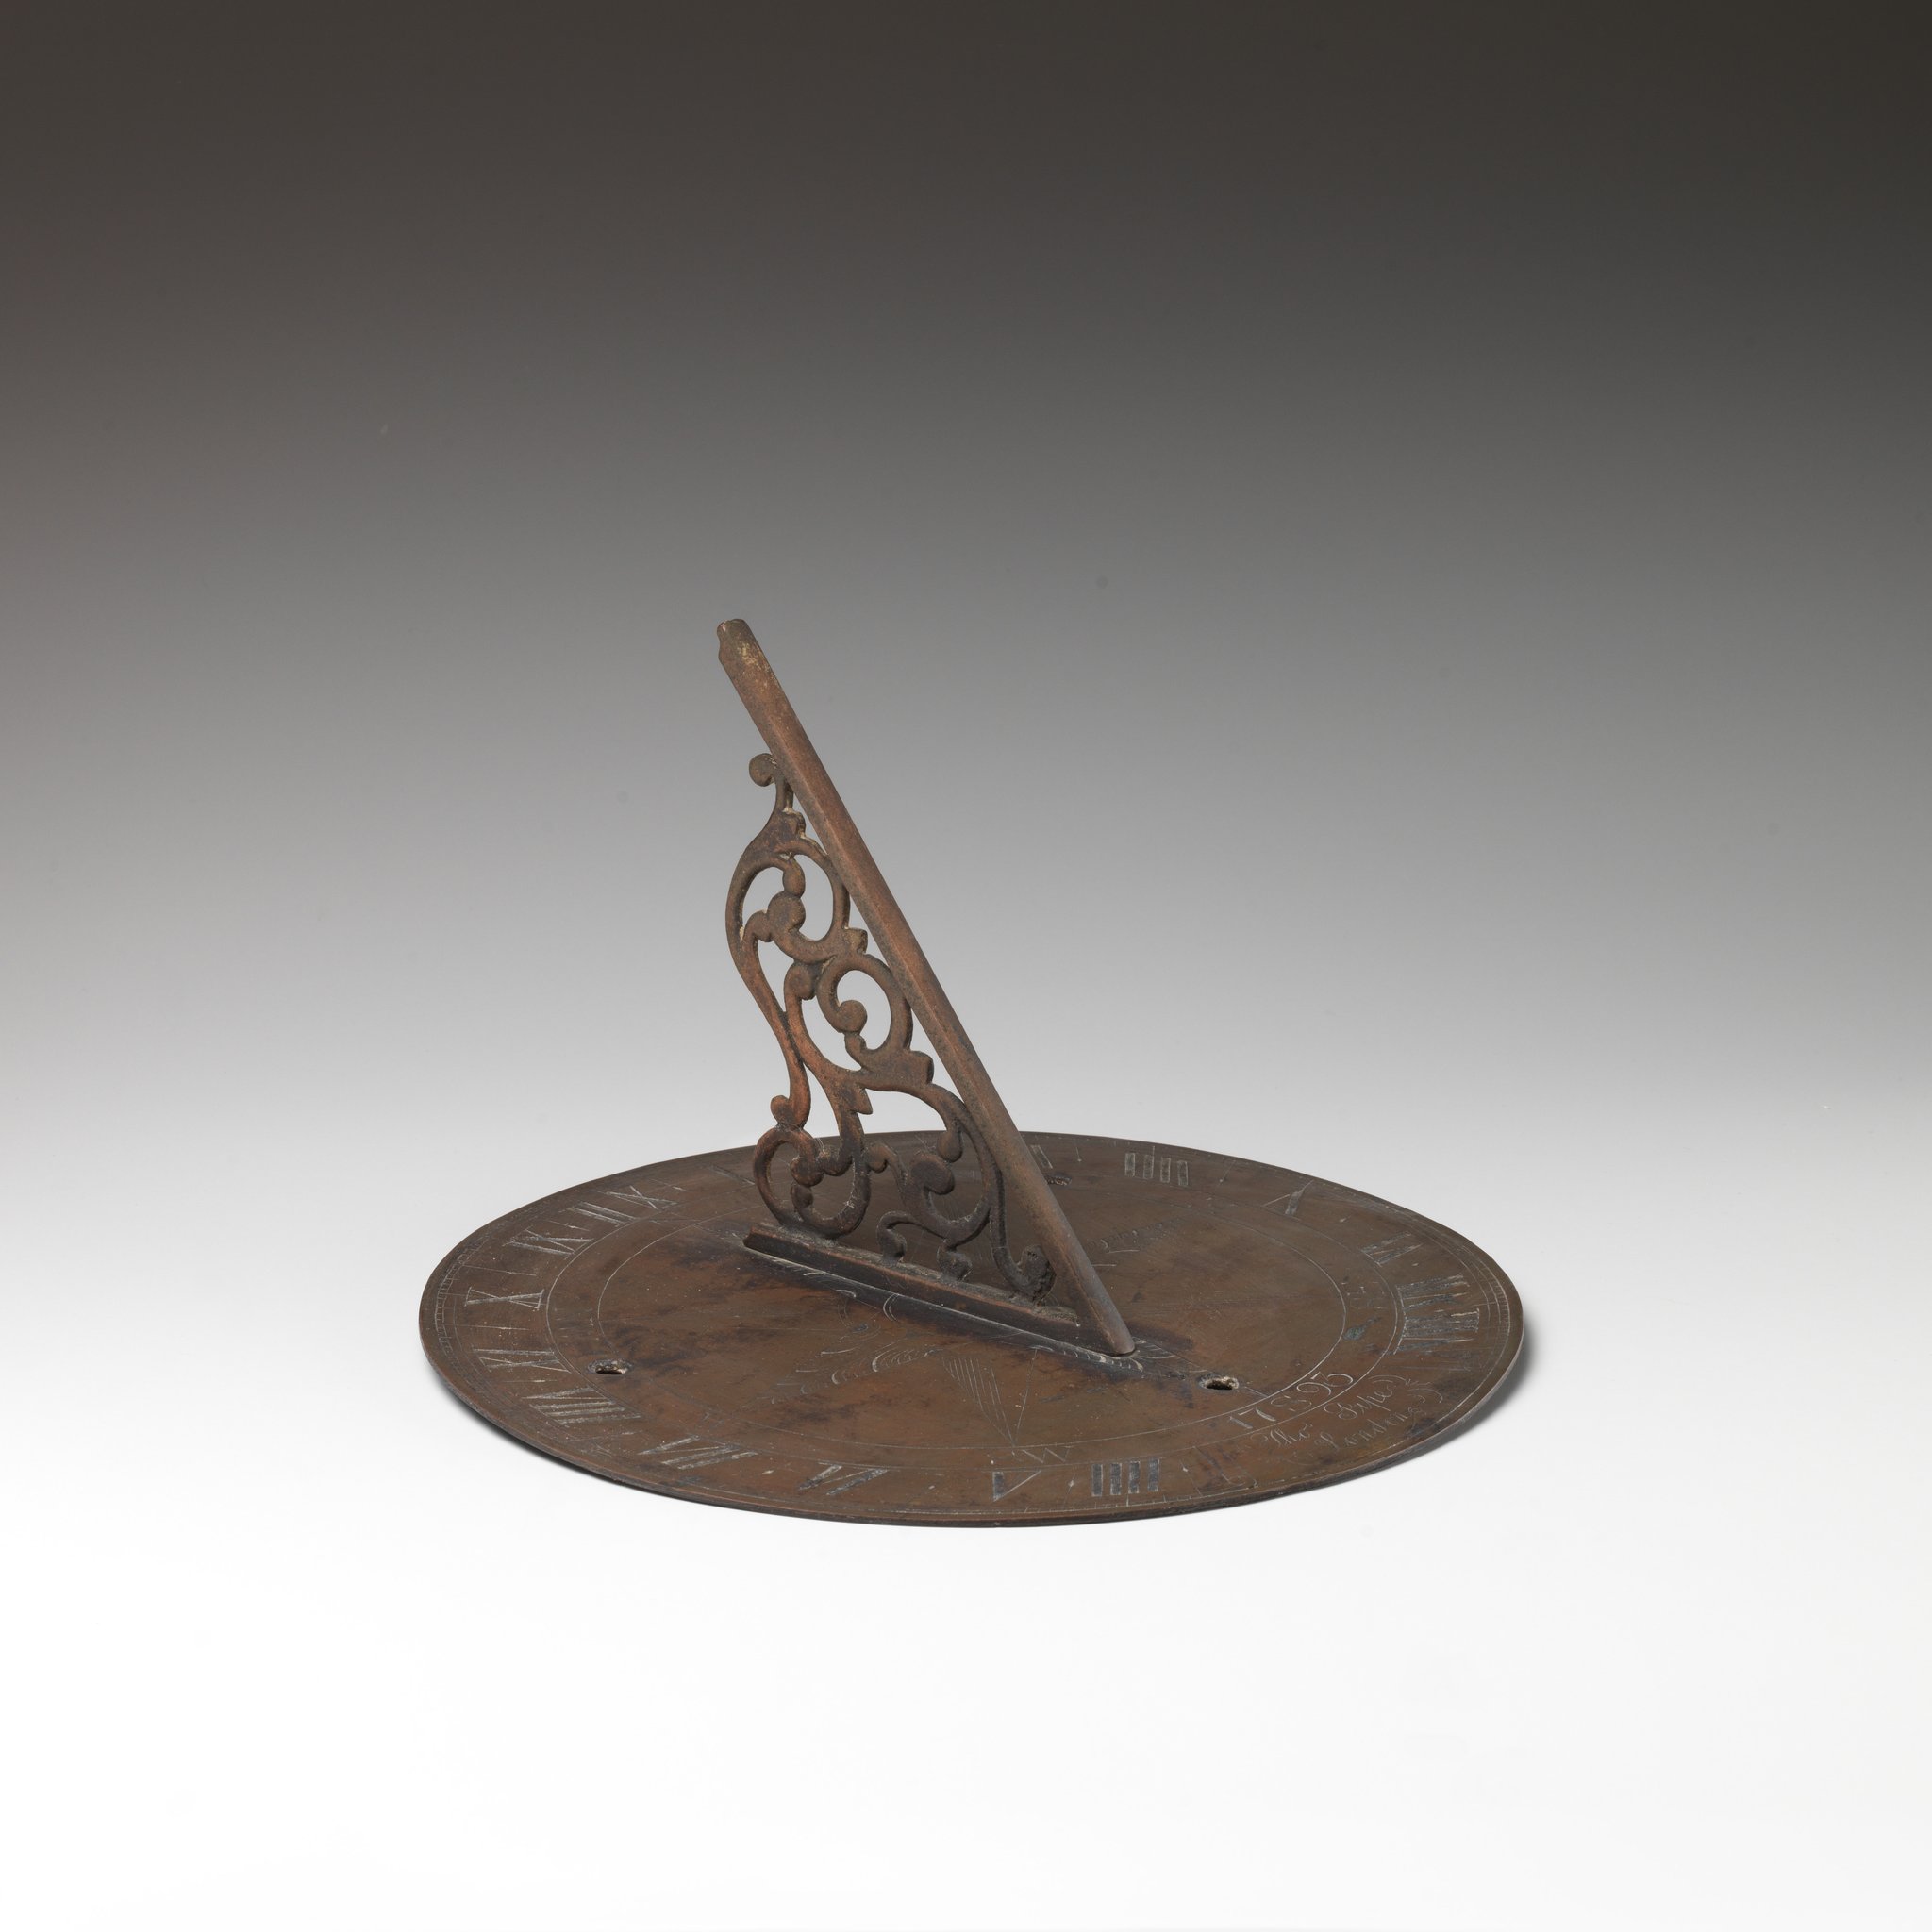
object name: stationary horizontal sundial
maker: thomas pipe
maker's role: maker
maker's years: 1750-1850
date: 1793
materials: brass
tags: sundials